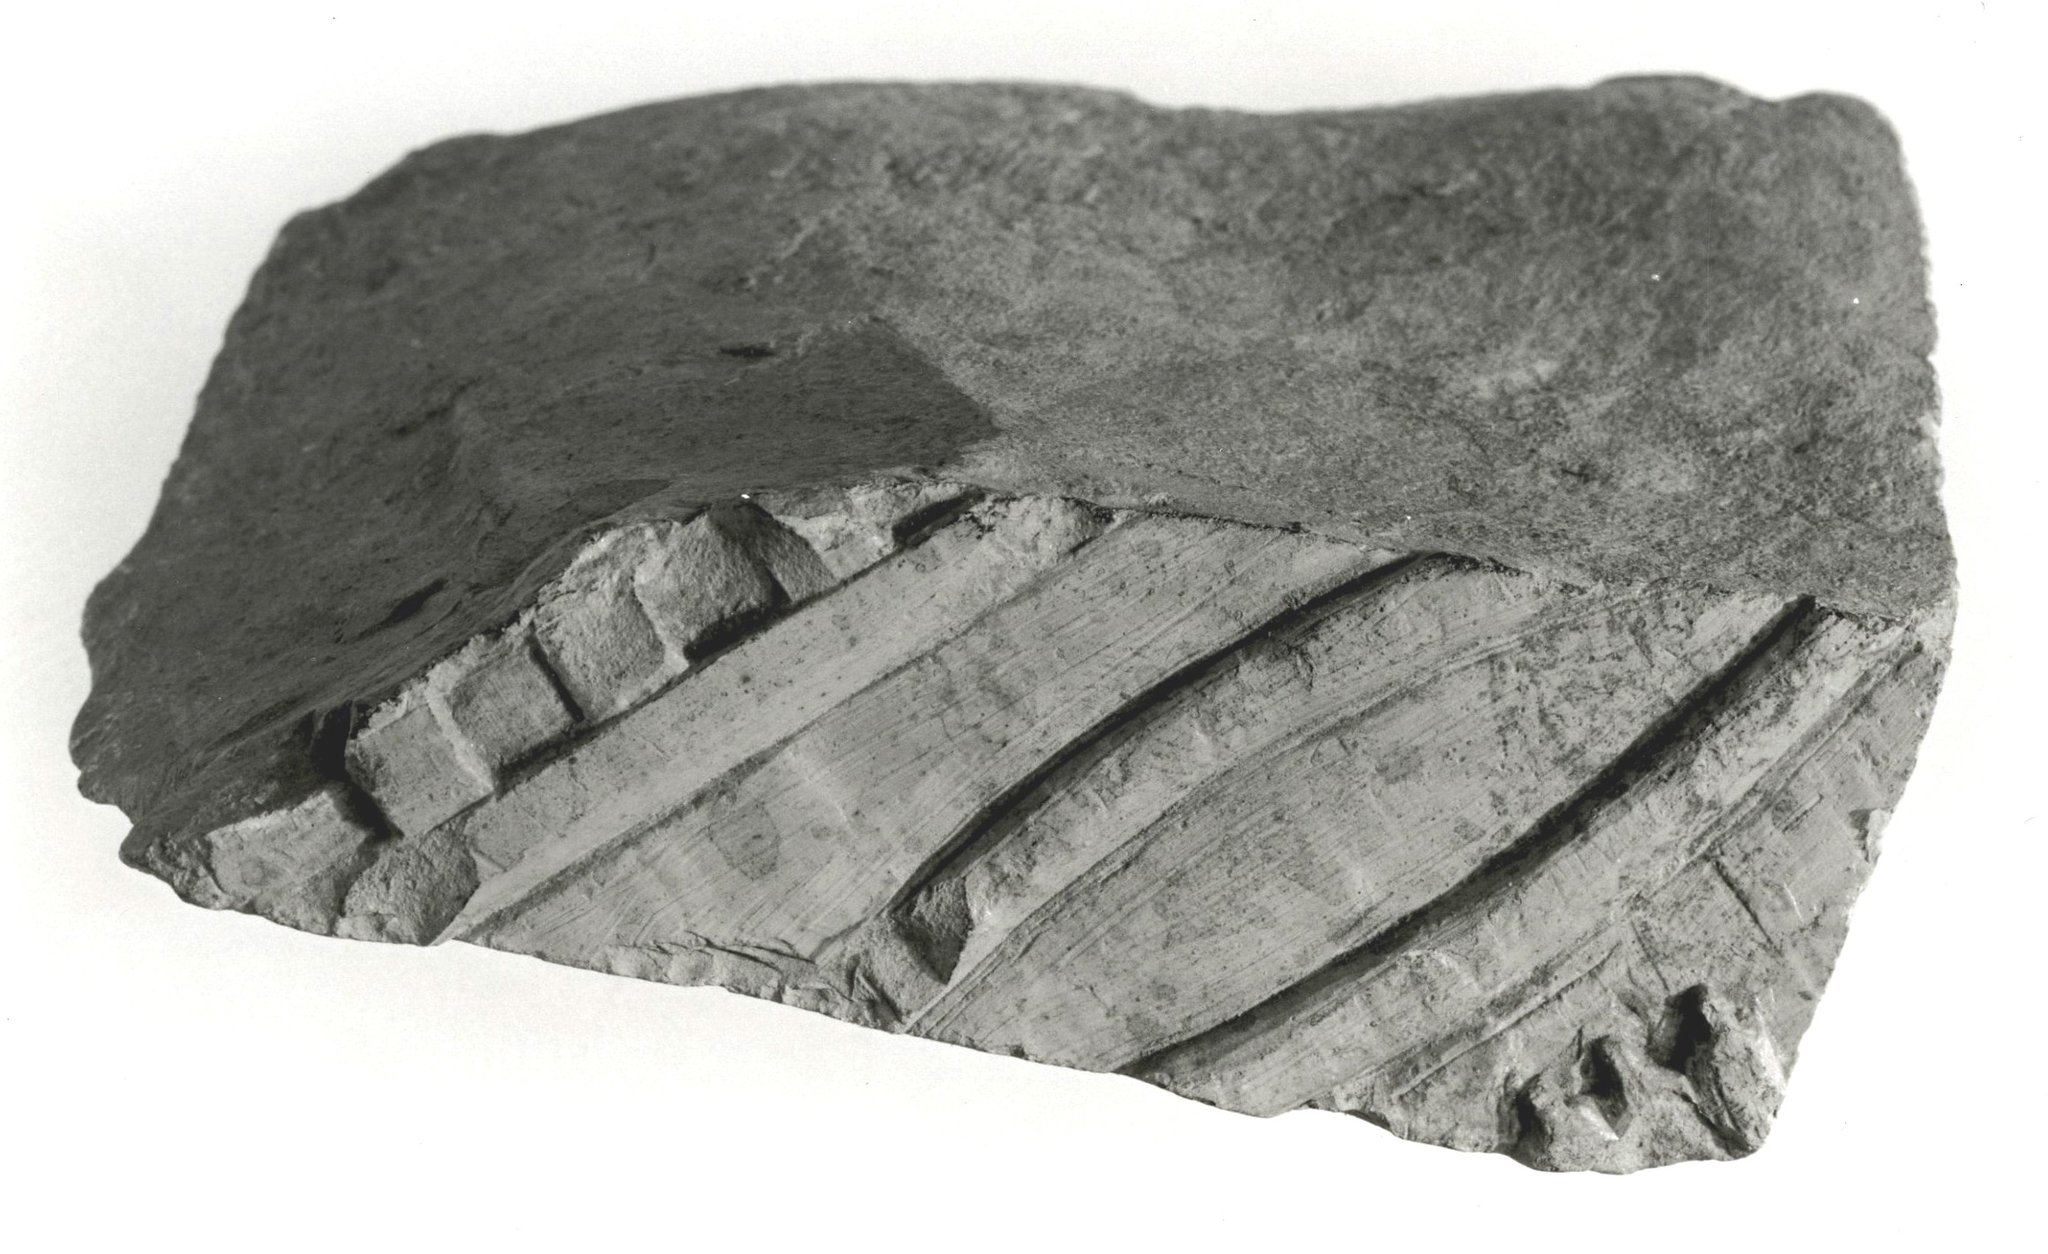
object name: relief, tomb of nespekashuty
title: Raised relief fragment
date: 664-610 BCE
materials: limestone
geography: egypt